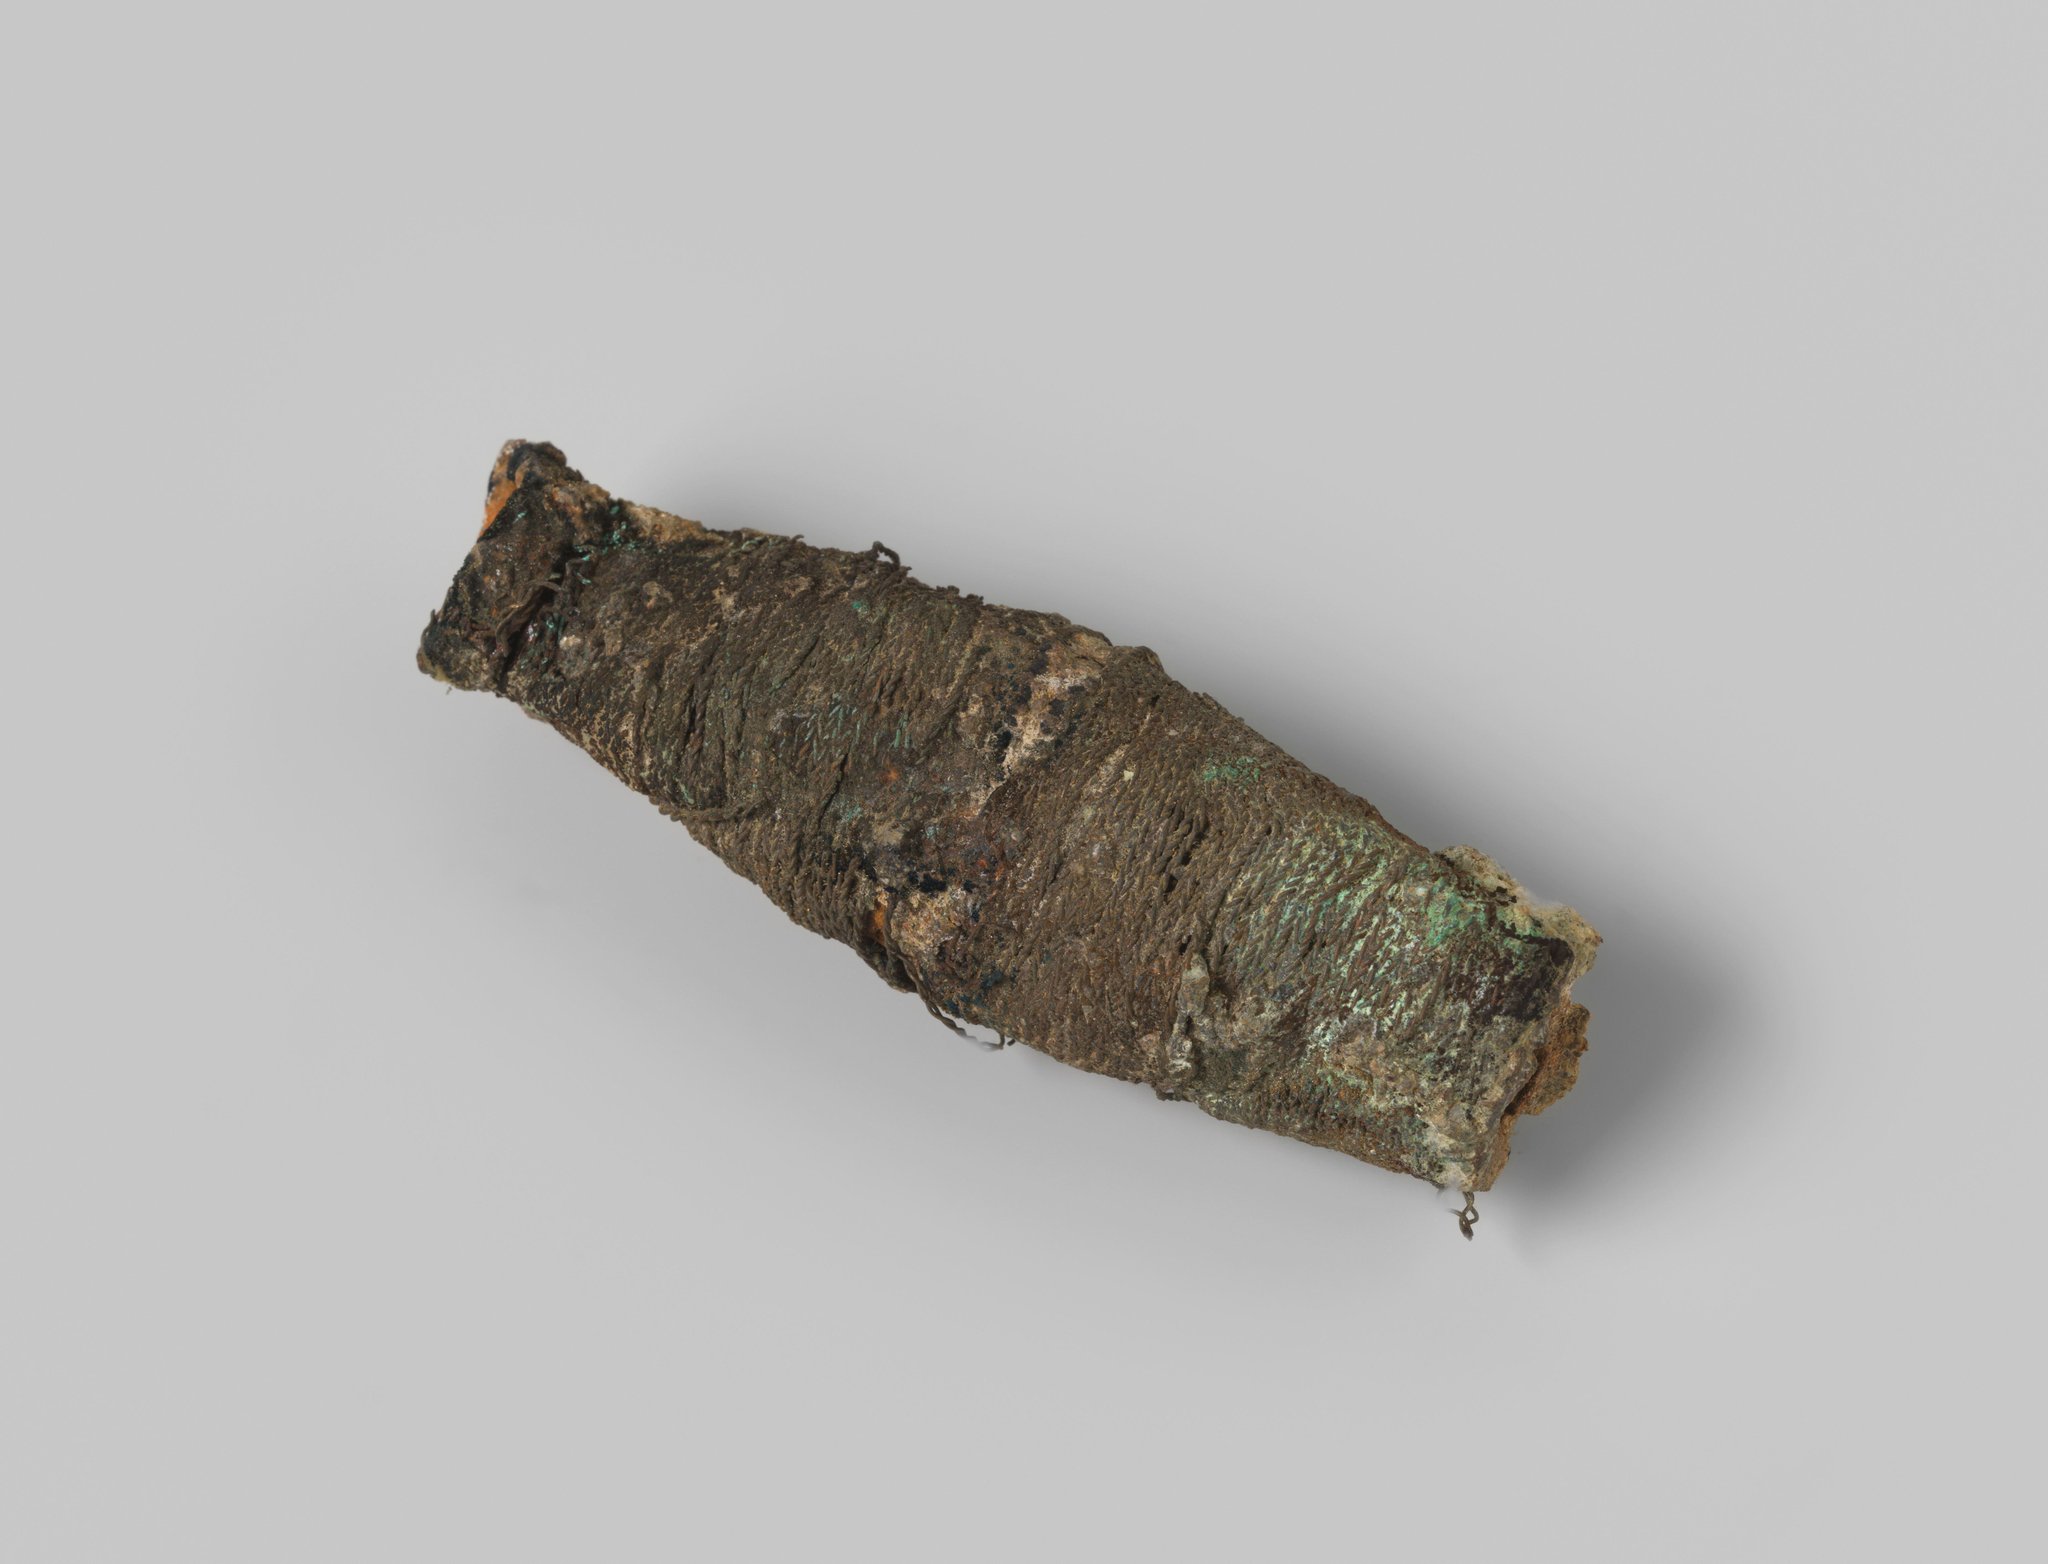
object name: greep gevest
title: Greep van een gevest uit het wrak van de Oost-Indiëvaarder Hollandia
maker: Anonymous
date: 1700-1743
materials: copper, wood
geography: netherlands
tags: verenigde oostindische compagnie, hollandia (schip), annet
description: Hilt, grip; id. NG 1980-27H2582, damaged, 1 ferrule missing.